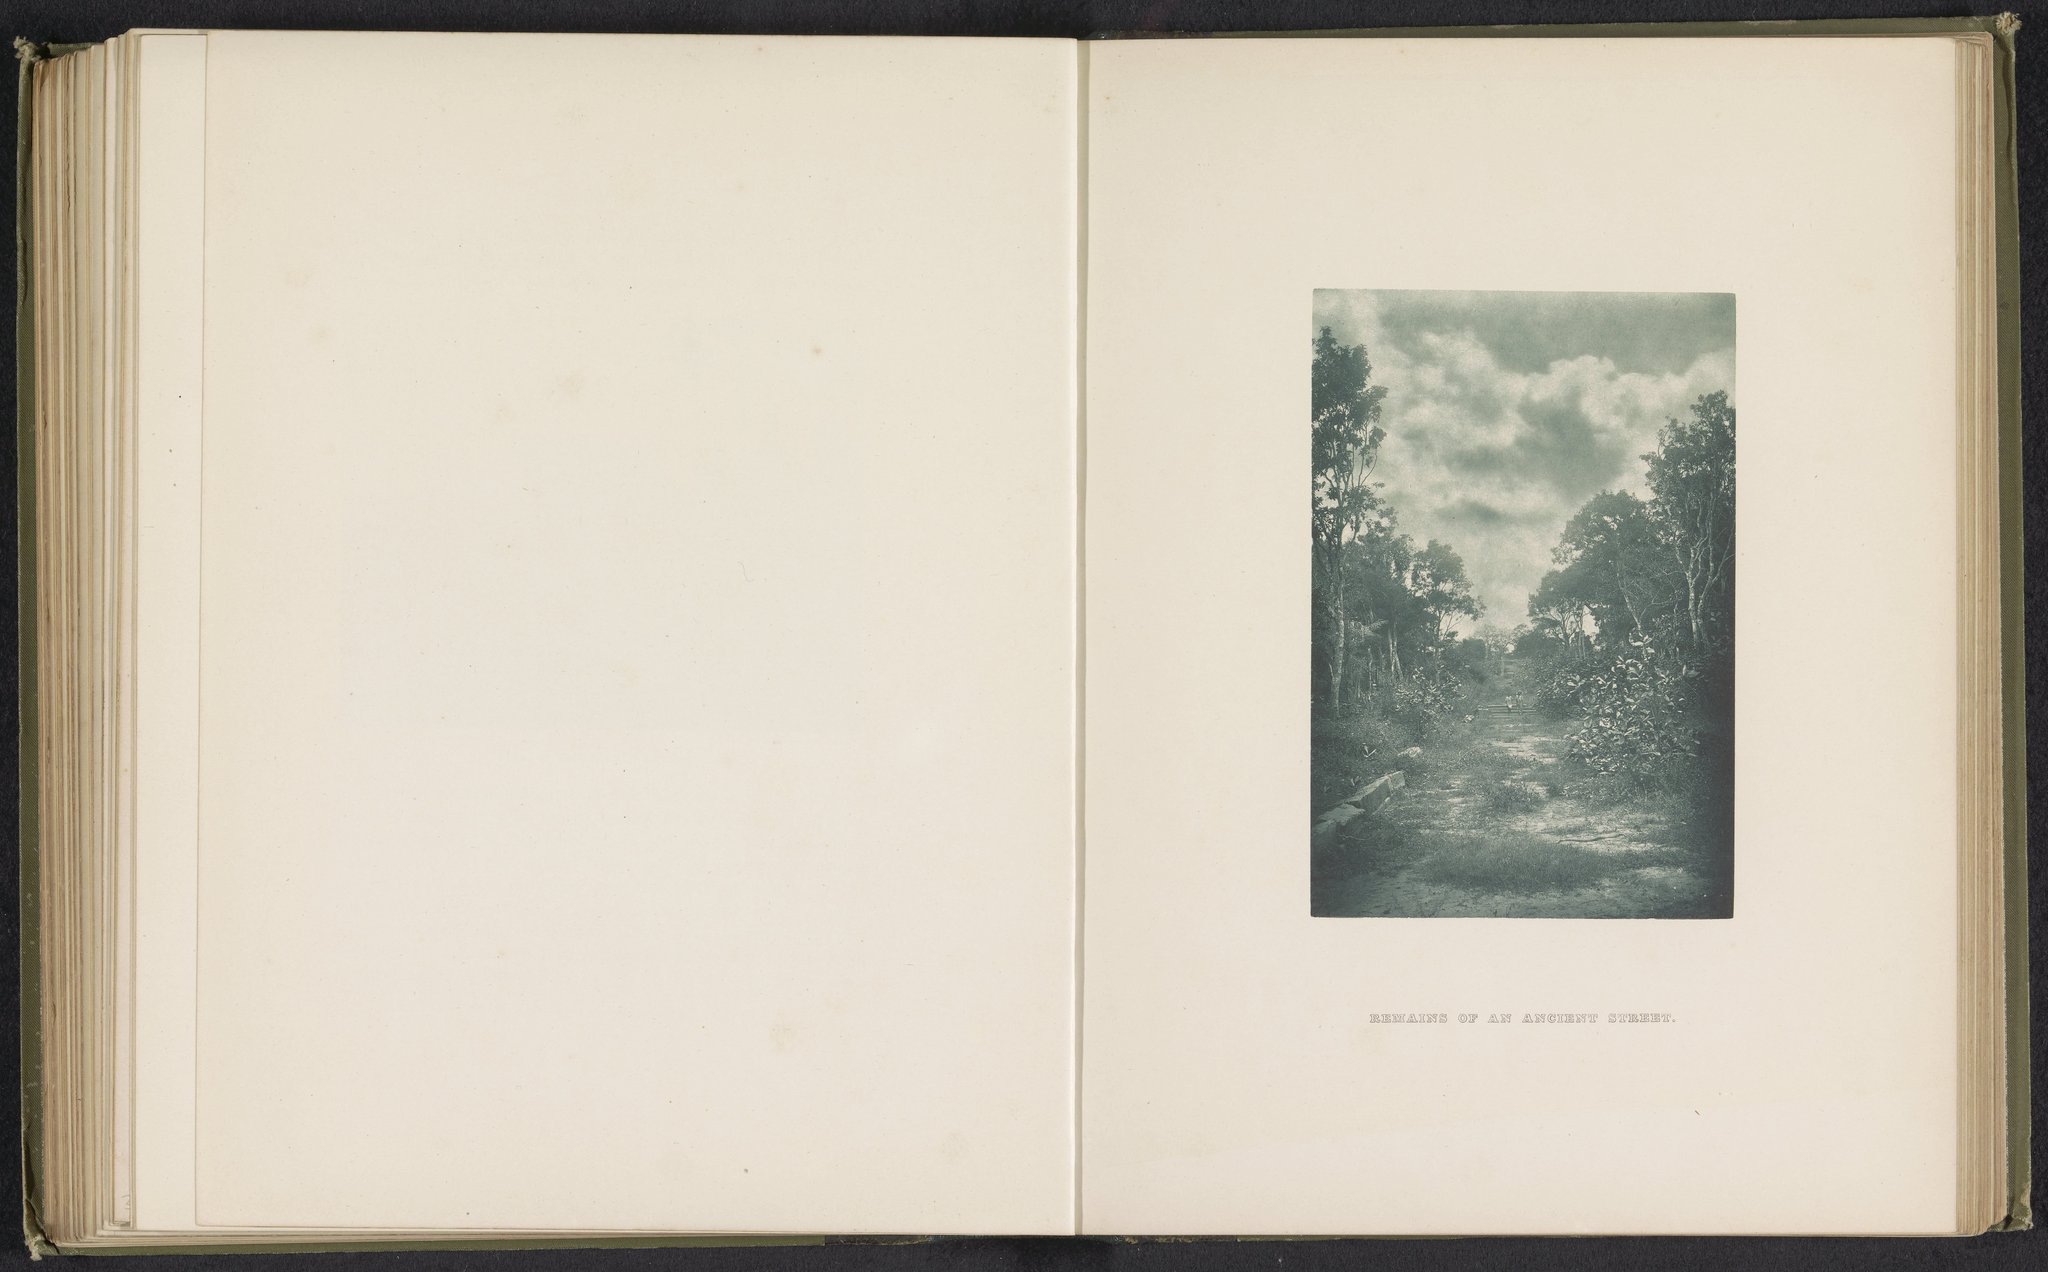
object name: photomechanical print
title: Remains of an ancient street at Anuradhapura, Sri Lanka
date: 1896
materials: paper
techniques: woodburygravure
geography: anuradhapura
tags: landscape with ruins, street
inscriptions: title: ‘REMAINS OF AN ANCIENT STREET.’